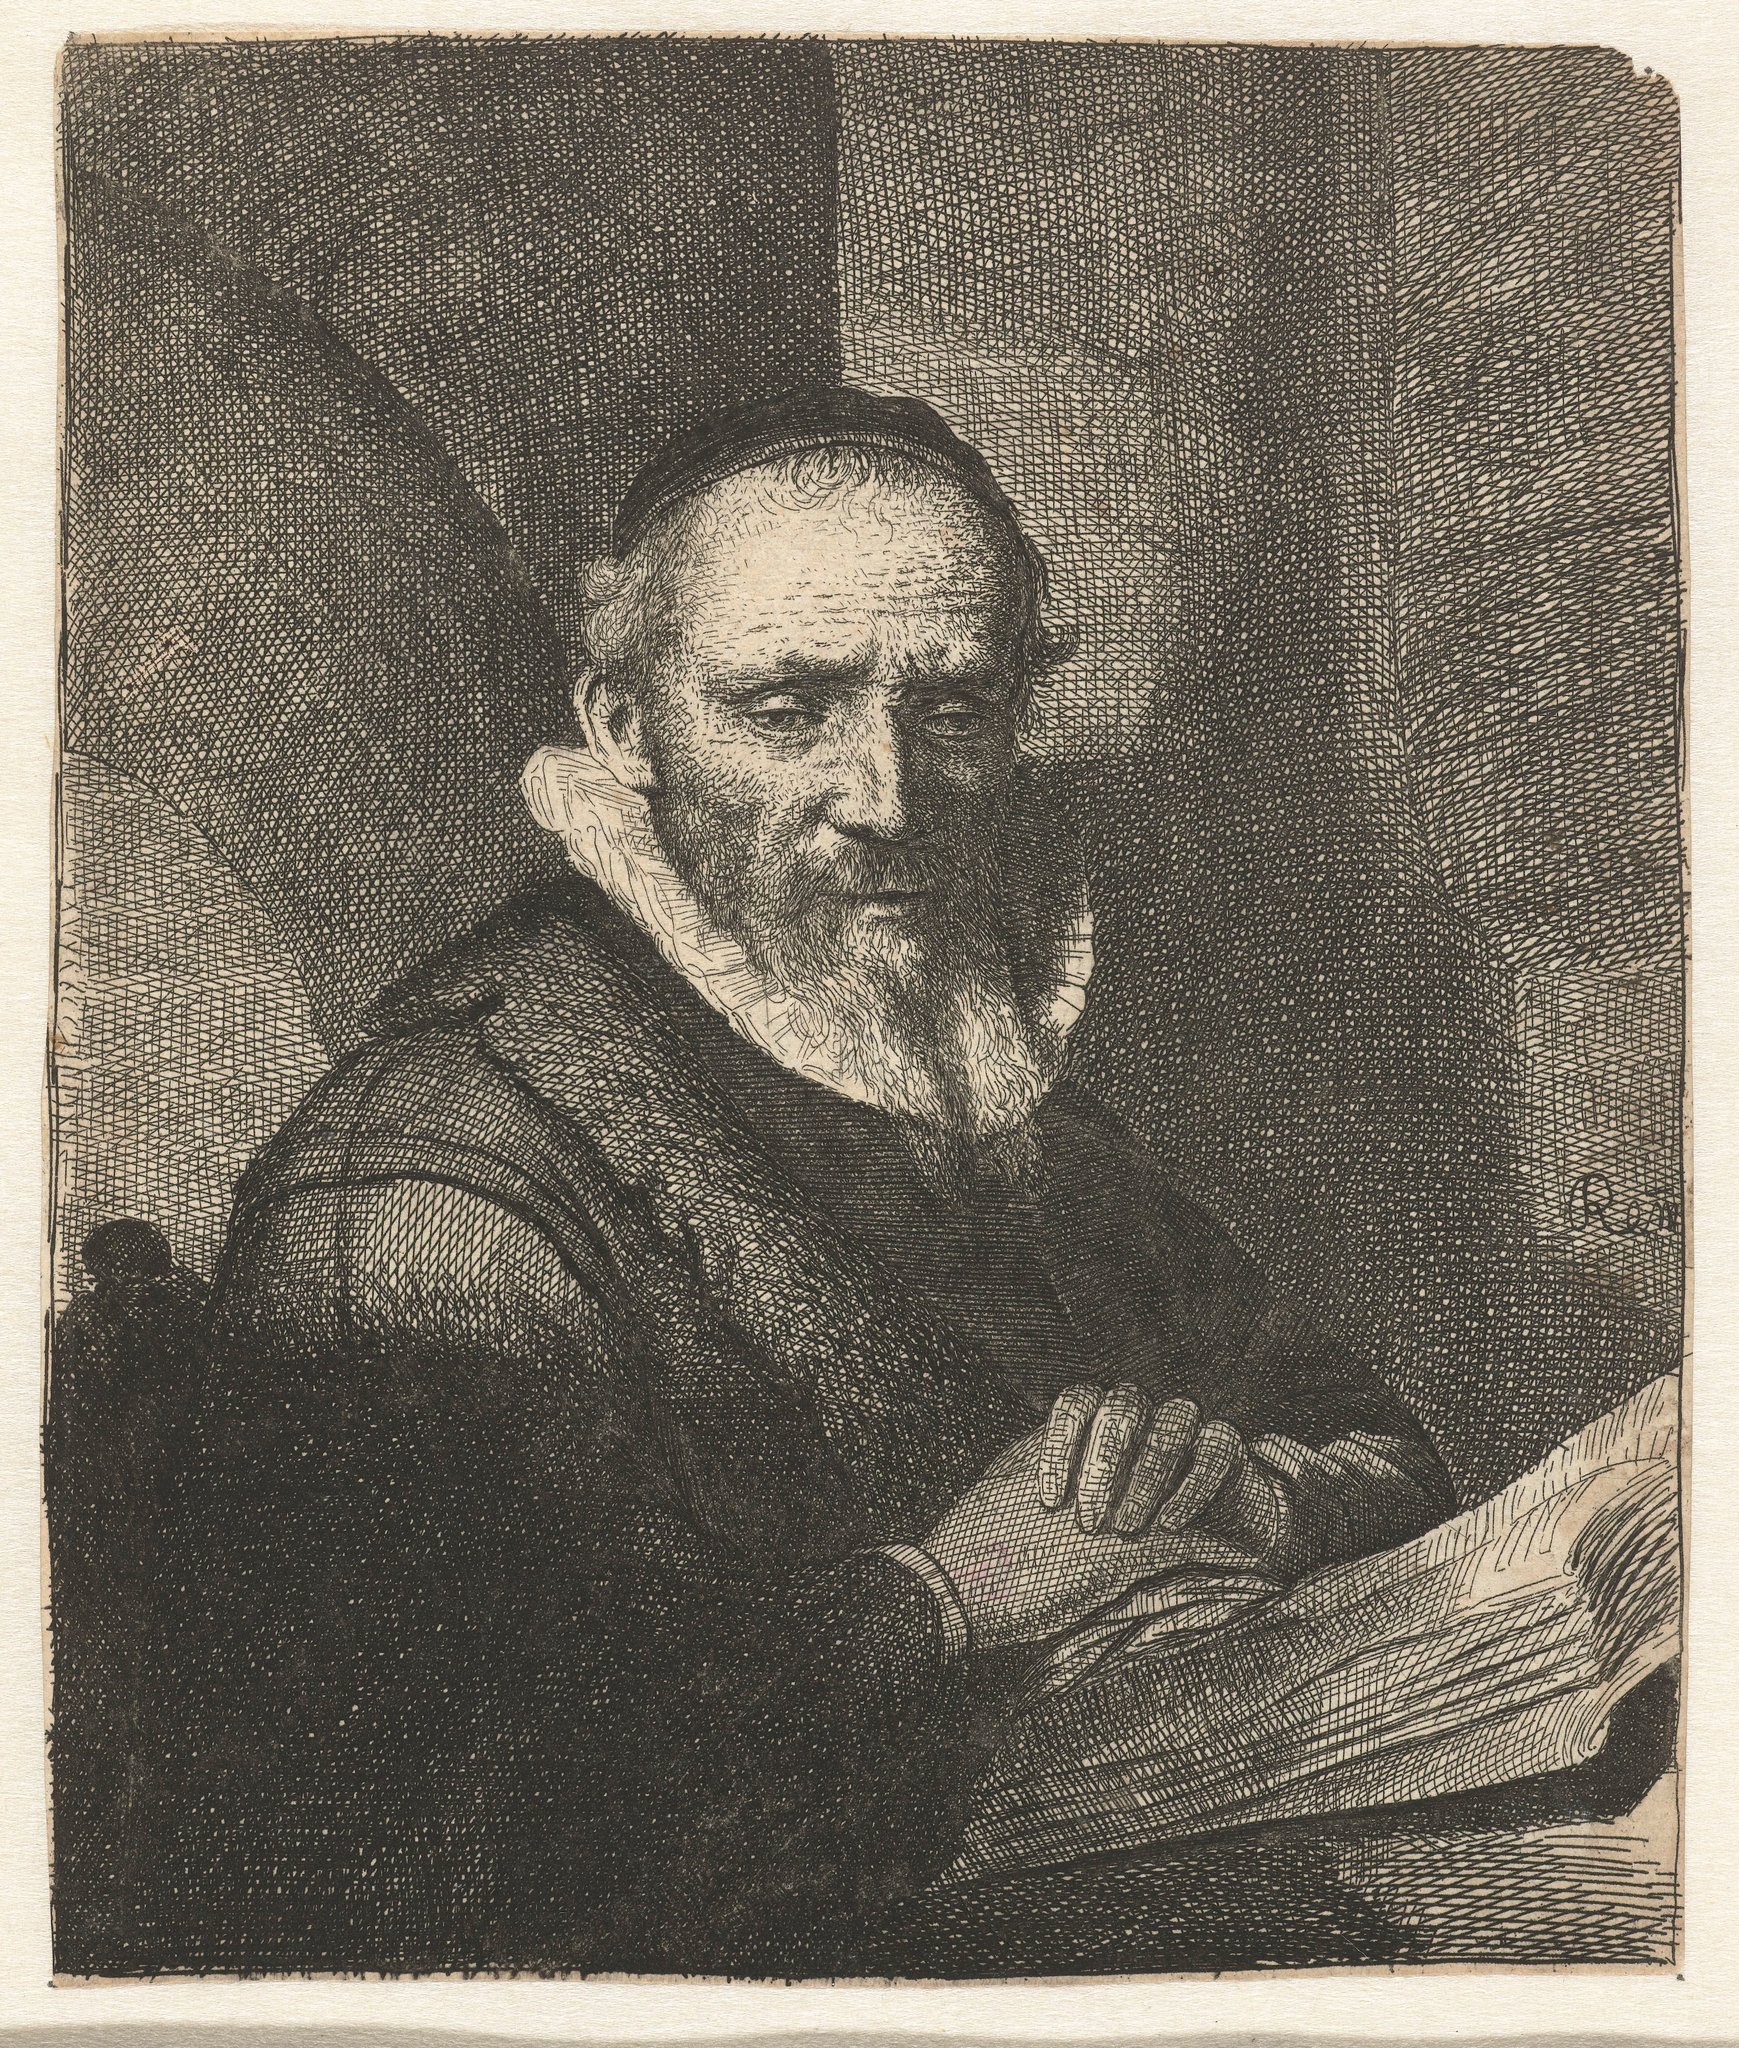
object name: print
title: Jan Cornelis Sylvius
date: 1633-1683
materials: paper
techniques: etching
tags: theologian, historical persons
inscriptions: collector's mark: Lugt 4071, collector's mark: Lugt 2228, collector's mark: Lugt 2760